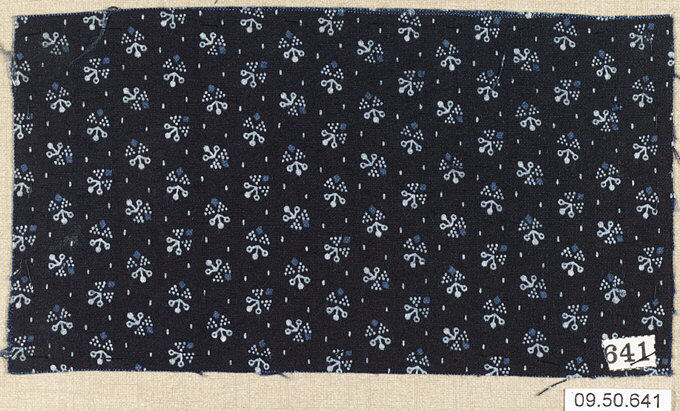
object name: piece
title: Pieces (8)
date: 1801-1900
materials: cotton